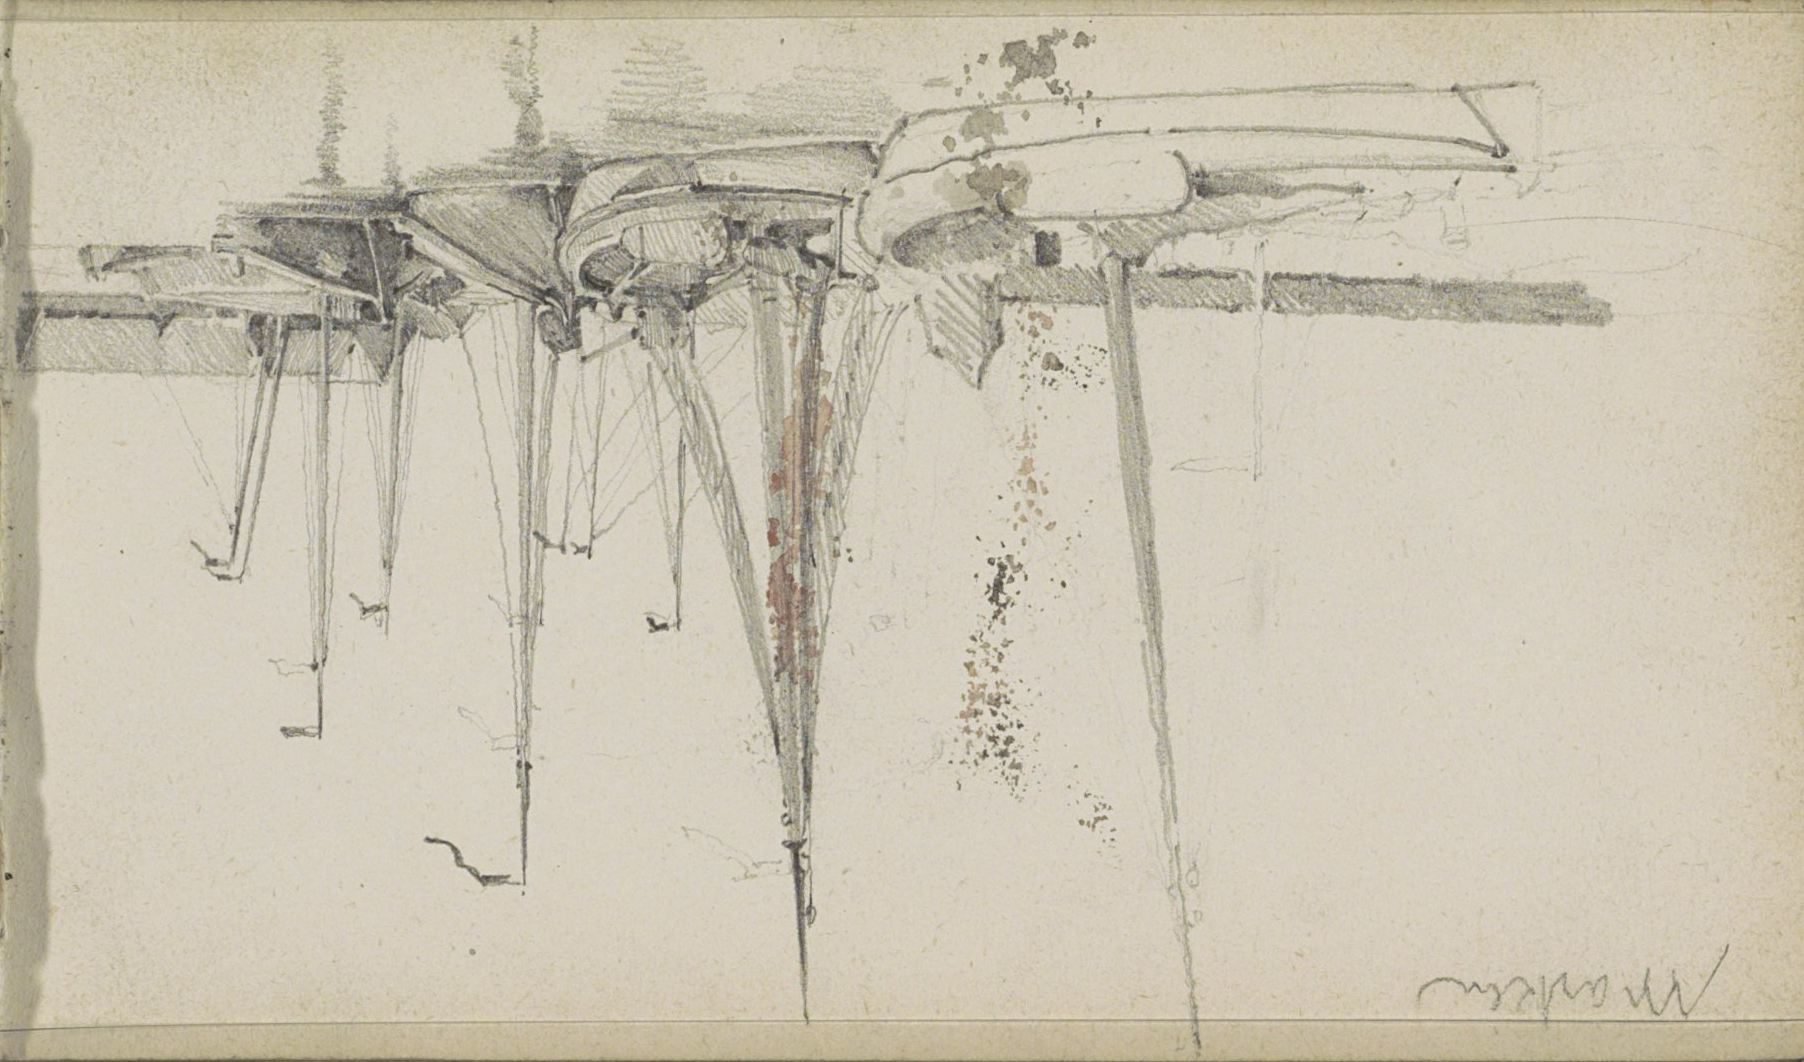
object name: sketchbook leaf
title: Zeilschepen in de haven van Marken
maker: george clausen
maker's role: draughtsman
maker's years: 1852-1912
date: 1875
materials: paper, pencil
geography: marken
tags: harbour, sailing-ship, sailing-boat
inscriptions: annotation: ‘Marken’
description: Blad 14 recto uit een schetsboek met 46 bladen.